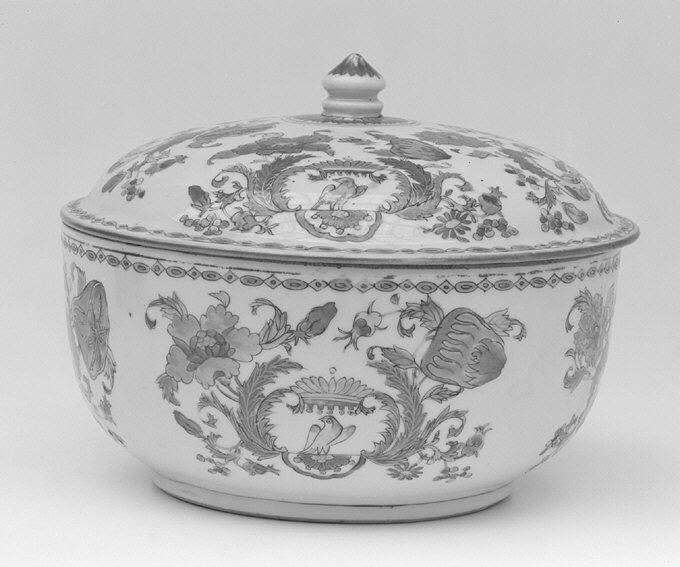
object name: bowl with cover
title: Bowl with cover (part of a set)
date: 1725-1740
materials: hard paste porcelain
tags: birds,flowers